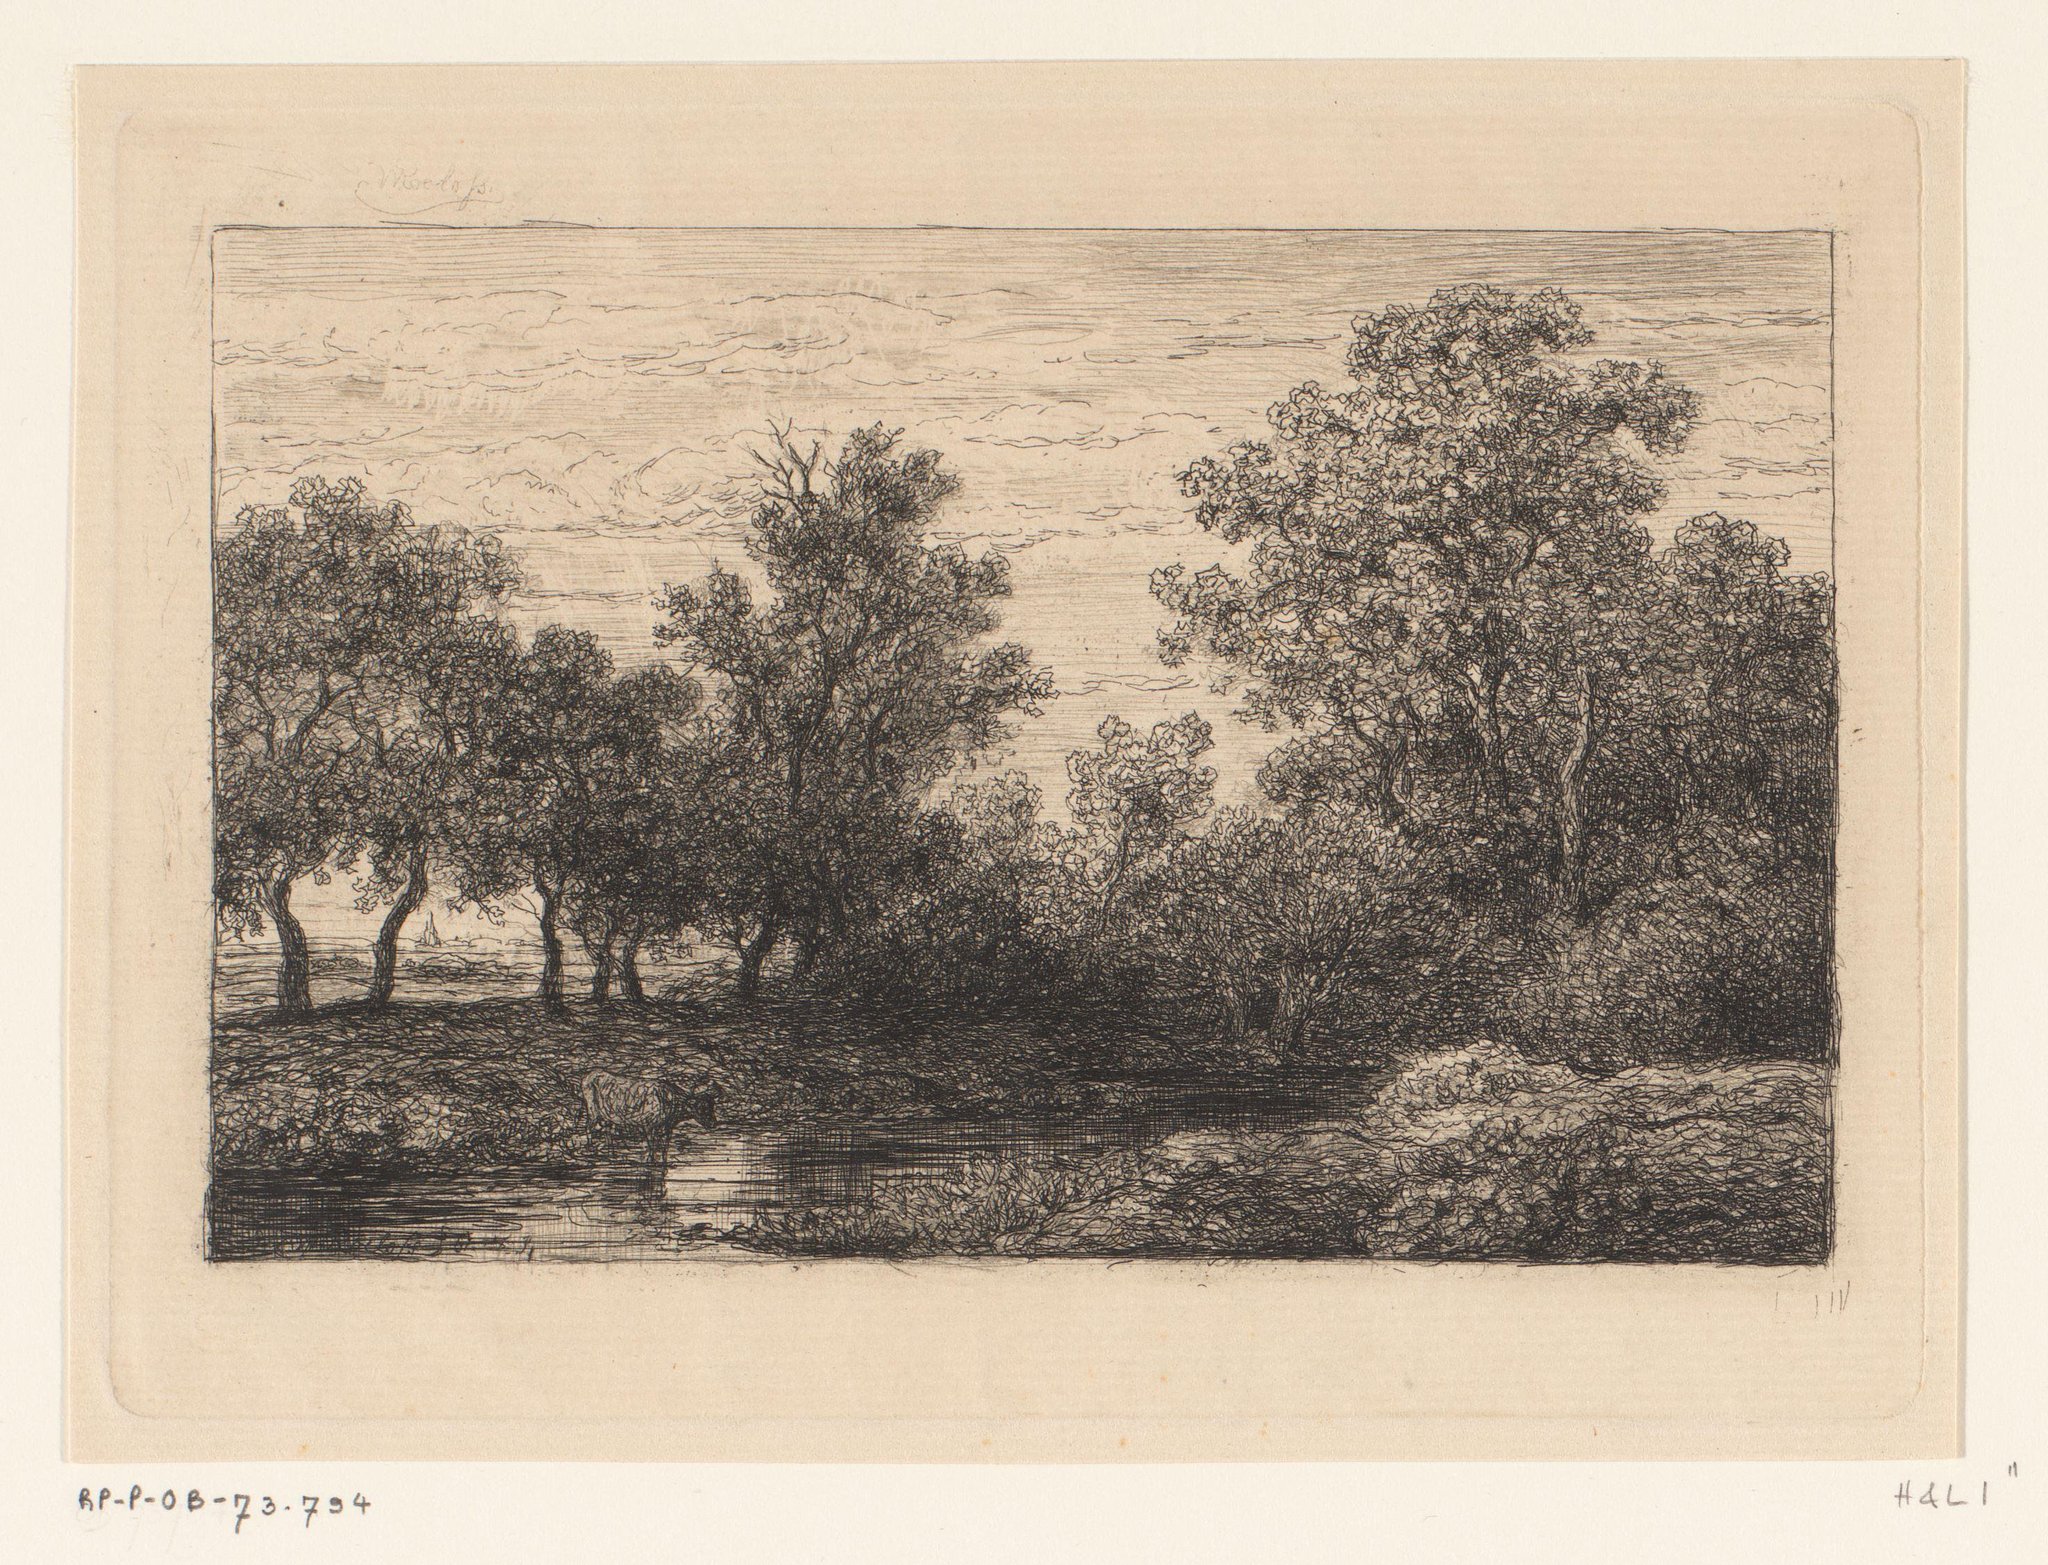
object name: print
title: Beek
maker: willem roelofs (i)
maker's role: draughtsman, painter, print maker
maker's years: 1822-1897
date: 1851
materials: paper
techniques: etching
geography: brussels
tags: cow, church (exterior), brook, groups of trees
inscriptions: collector's mark: Lugt 2228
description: Een boomrijk landschap met links op de voorgrond een koe bij een beek. Op de achtergrond de contouren van een kerk.